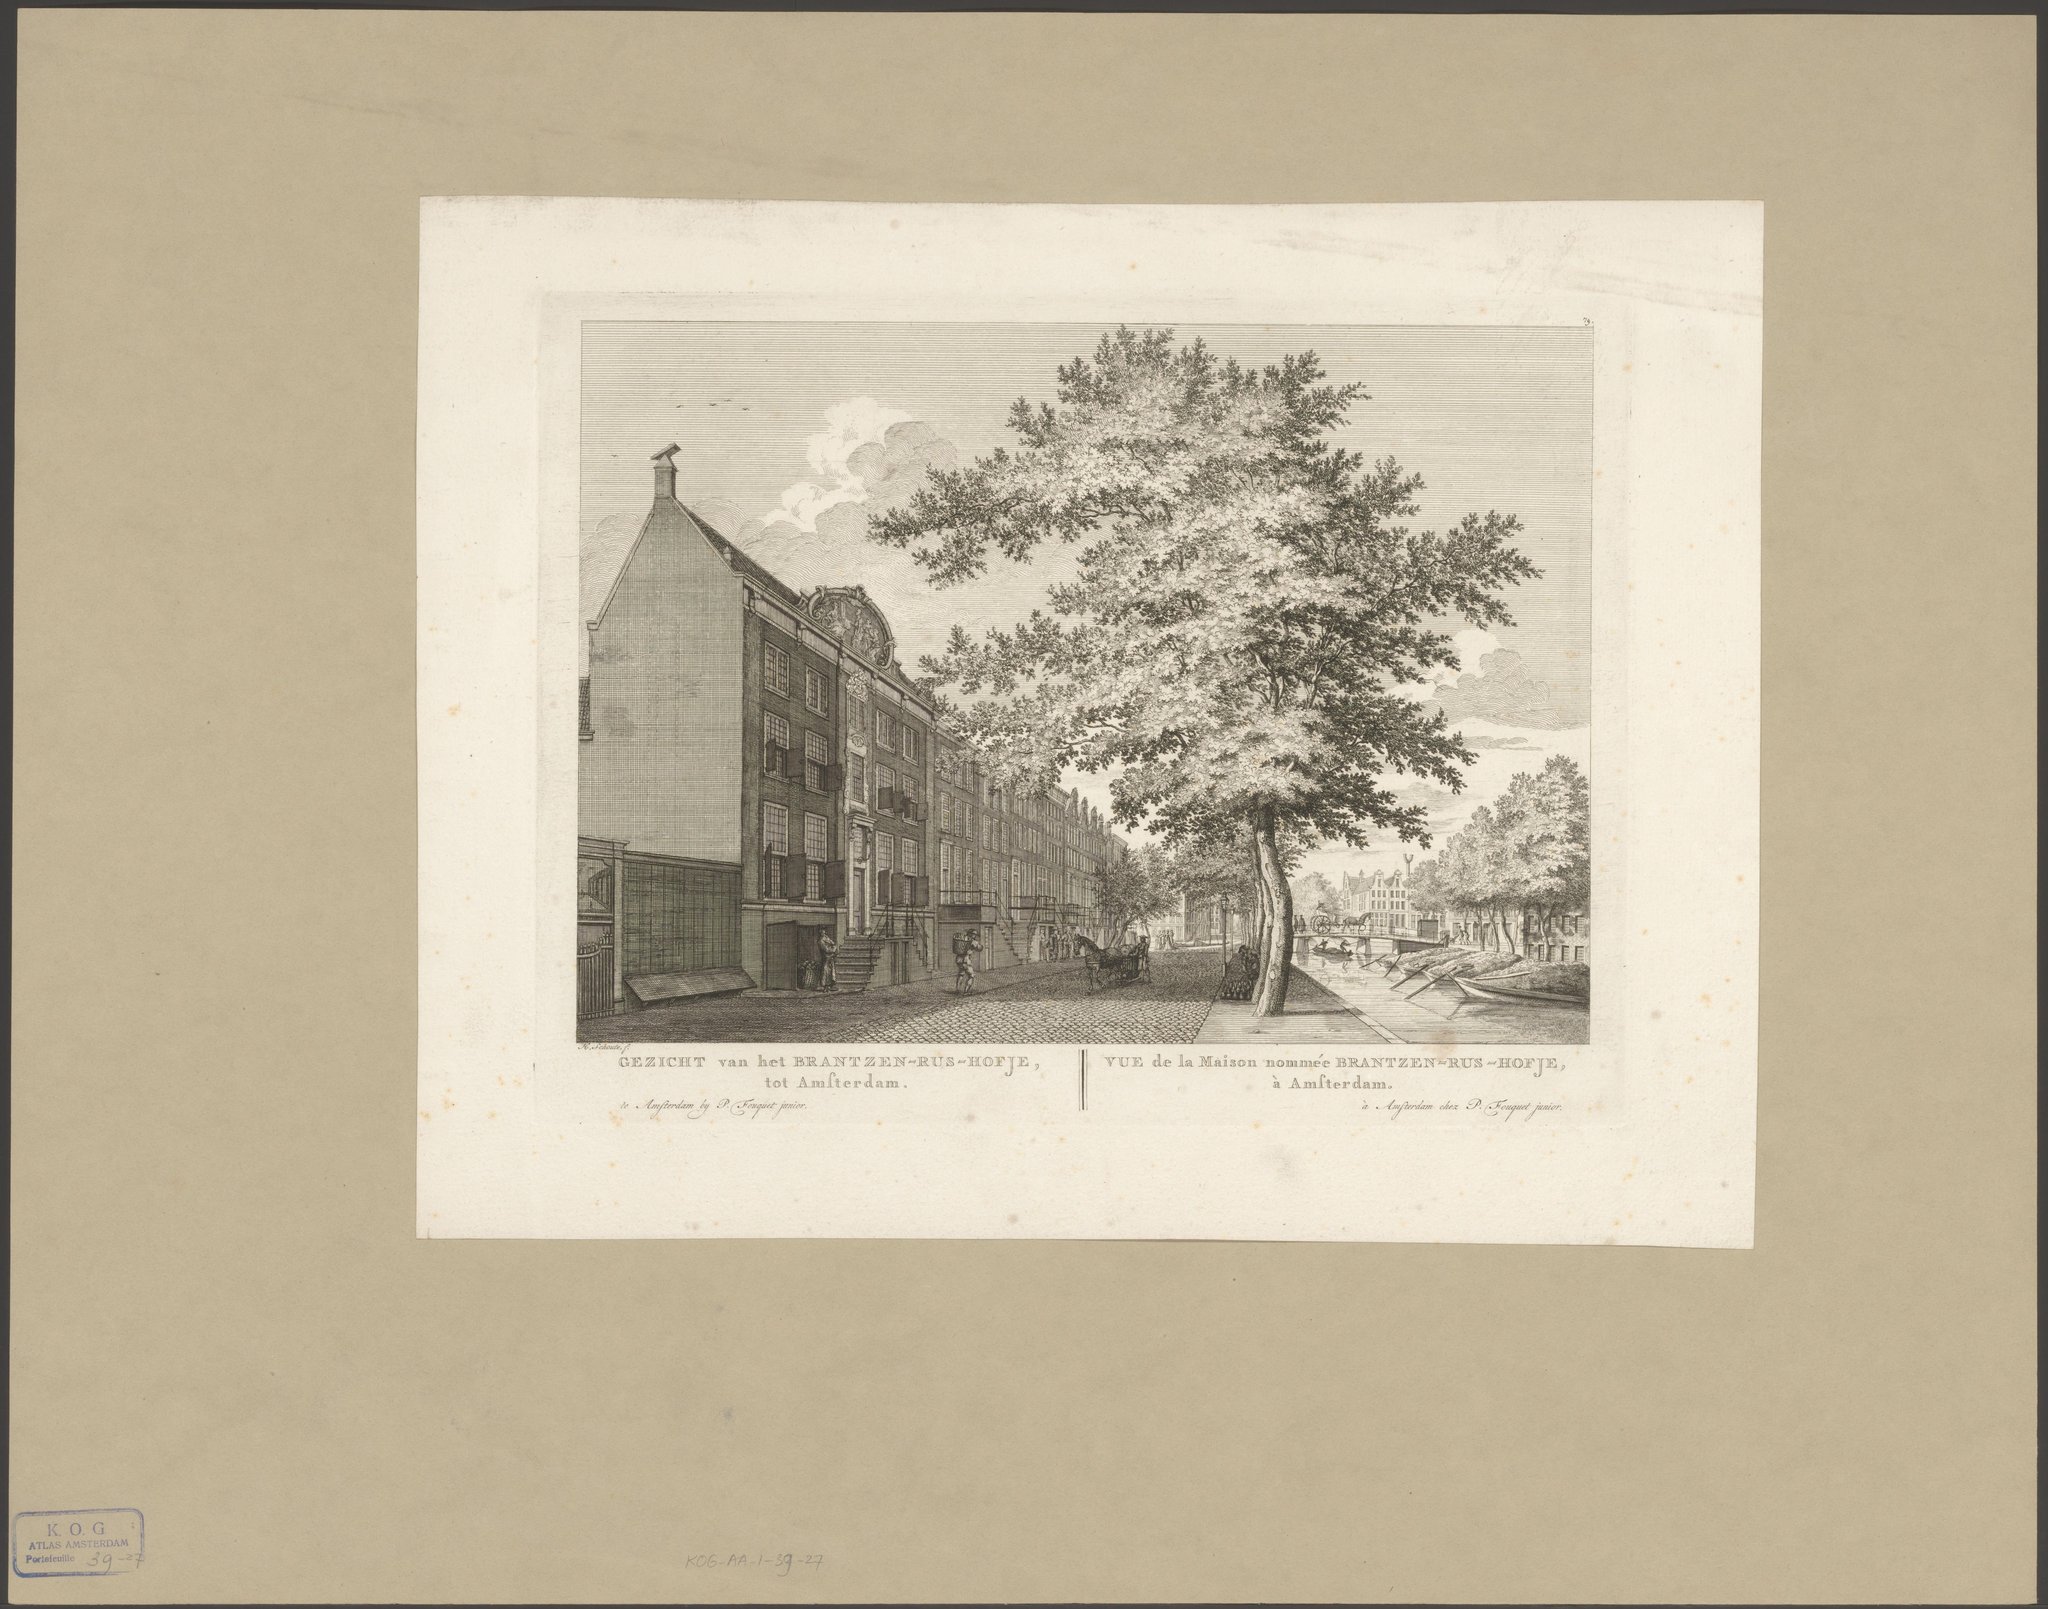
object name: print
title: Gezicht van het Brantzen-Rus-Hofje, tot Amsterdam / Vue de la Maison nommée Brantzen-Rus-Hofje, à Amsterdam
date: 1770-1783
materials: paper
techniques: engraving, etching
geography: amsterdam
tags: alms-house (dutch: 'hofje'), bridge in city across river, canal, etc. (+ city(-scape) with figures, staffage), canals, waters (in city) (+ city(-scape) with figures, staffage), street (+ city(-scape) with figures, staffage)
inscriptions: collector's mark: Lugt 1641b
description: Vanaf 1760 gaf Pierre Fouquet stadsgezichten van Amsterdam naar tekeningen van verschillende kunstenaars uit. Deze prenten werden aanvankelijk los verkocht. Later werden ze samengebonden verkocht in verschillende volgordes en aantallen in: (1). Afbeeldingen van de wyd-vermaarde koopstad Amsterdam benevens des zelvs voornaamste gebouwen en gezigten alle naar het leeven getekend / Receuil des edifices les plus considerables et des plus belles vues, de la fameuse ville d'Amsterdam, dessinées d'après nature. Amsterdam: Pierre Fouquet, 1778-1783. Deze 'uitgave' bestond waarschijnlijk alleen uit een titelblad en inhoudsopgave van de tot dusver 100 uitgegeven prenten, die de koper zelf aan zijn of haar reeds verzamelde prenten kon toevoegen. De hoeveelheid en volgorde van prenten verzameld onder deze titel verschilt dus sterk. (2). Nieuwe atlas, van de voornaamste gebouwen en gezigten der stad Amsterdam, met derzelver beknopte beschryvingen. 2 dln. Amsterdam: Daniël Jean Changuion en Petrus den Hengst [in opdracht van Pierre Fouquet], 1783. Ook werden er door verschillende uitgevers tussen 1788 (Amsterdam: Petrus Conradi) en 1805 (Amsterdam: Evert Maaskamp) heruitgaven gepubliceerd.